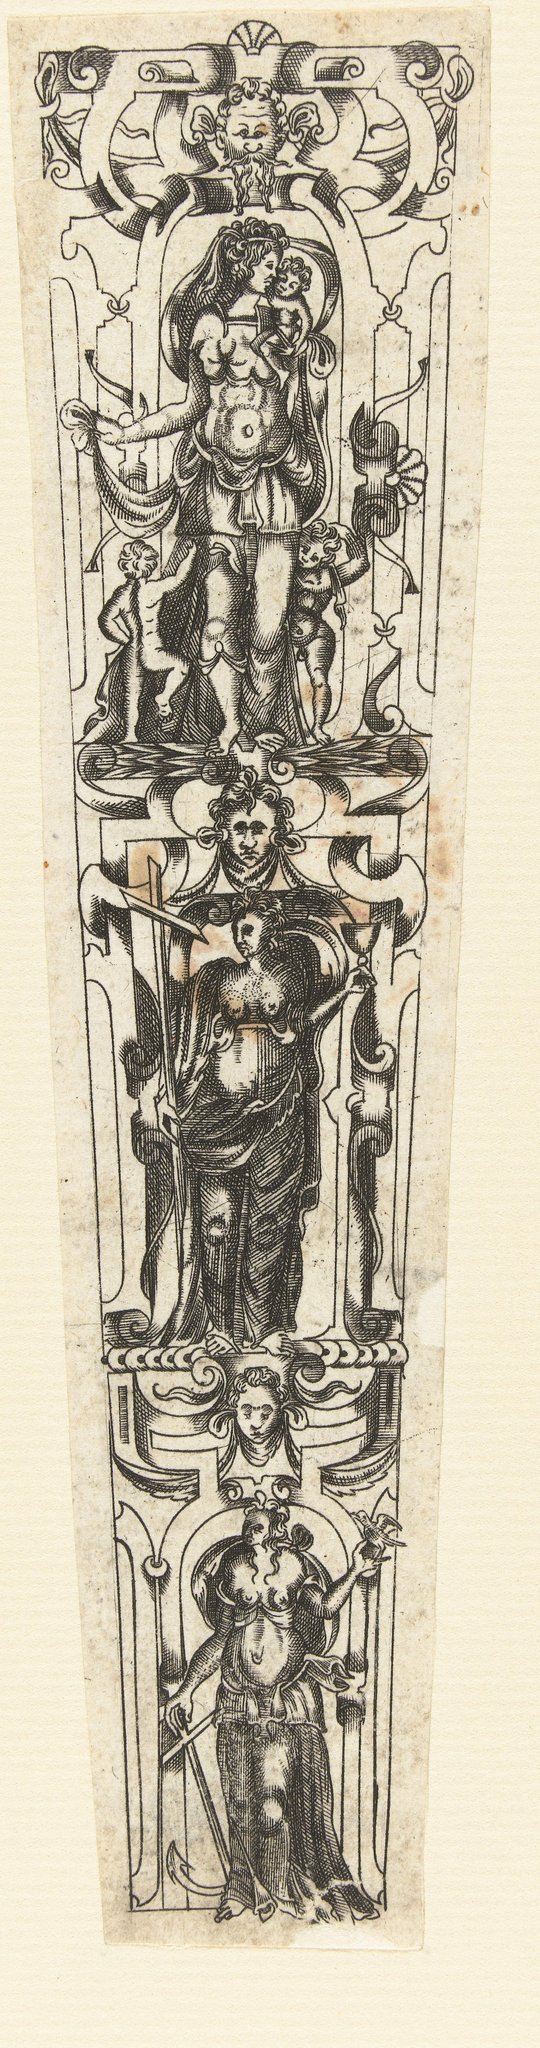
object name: print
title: Scheden, gedecoreerd met deugden in een omlijsting van rolwerk met mascarons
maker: Anonymous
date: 1500-1600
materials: paper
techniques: engraving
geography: germany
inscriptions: collector's mark: Lugt 240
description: Onderaan staat Spes, daarboven staat Fides en bovenaan staat Caritas.